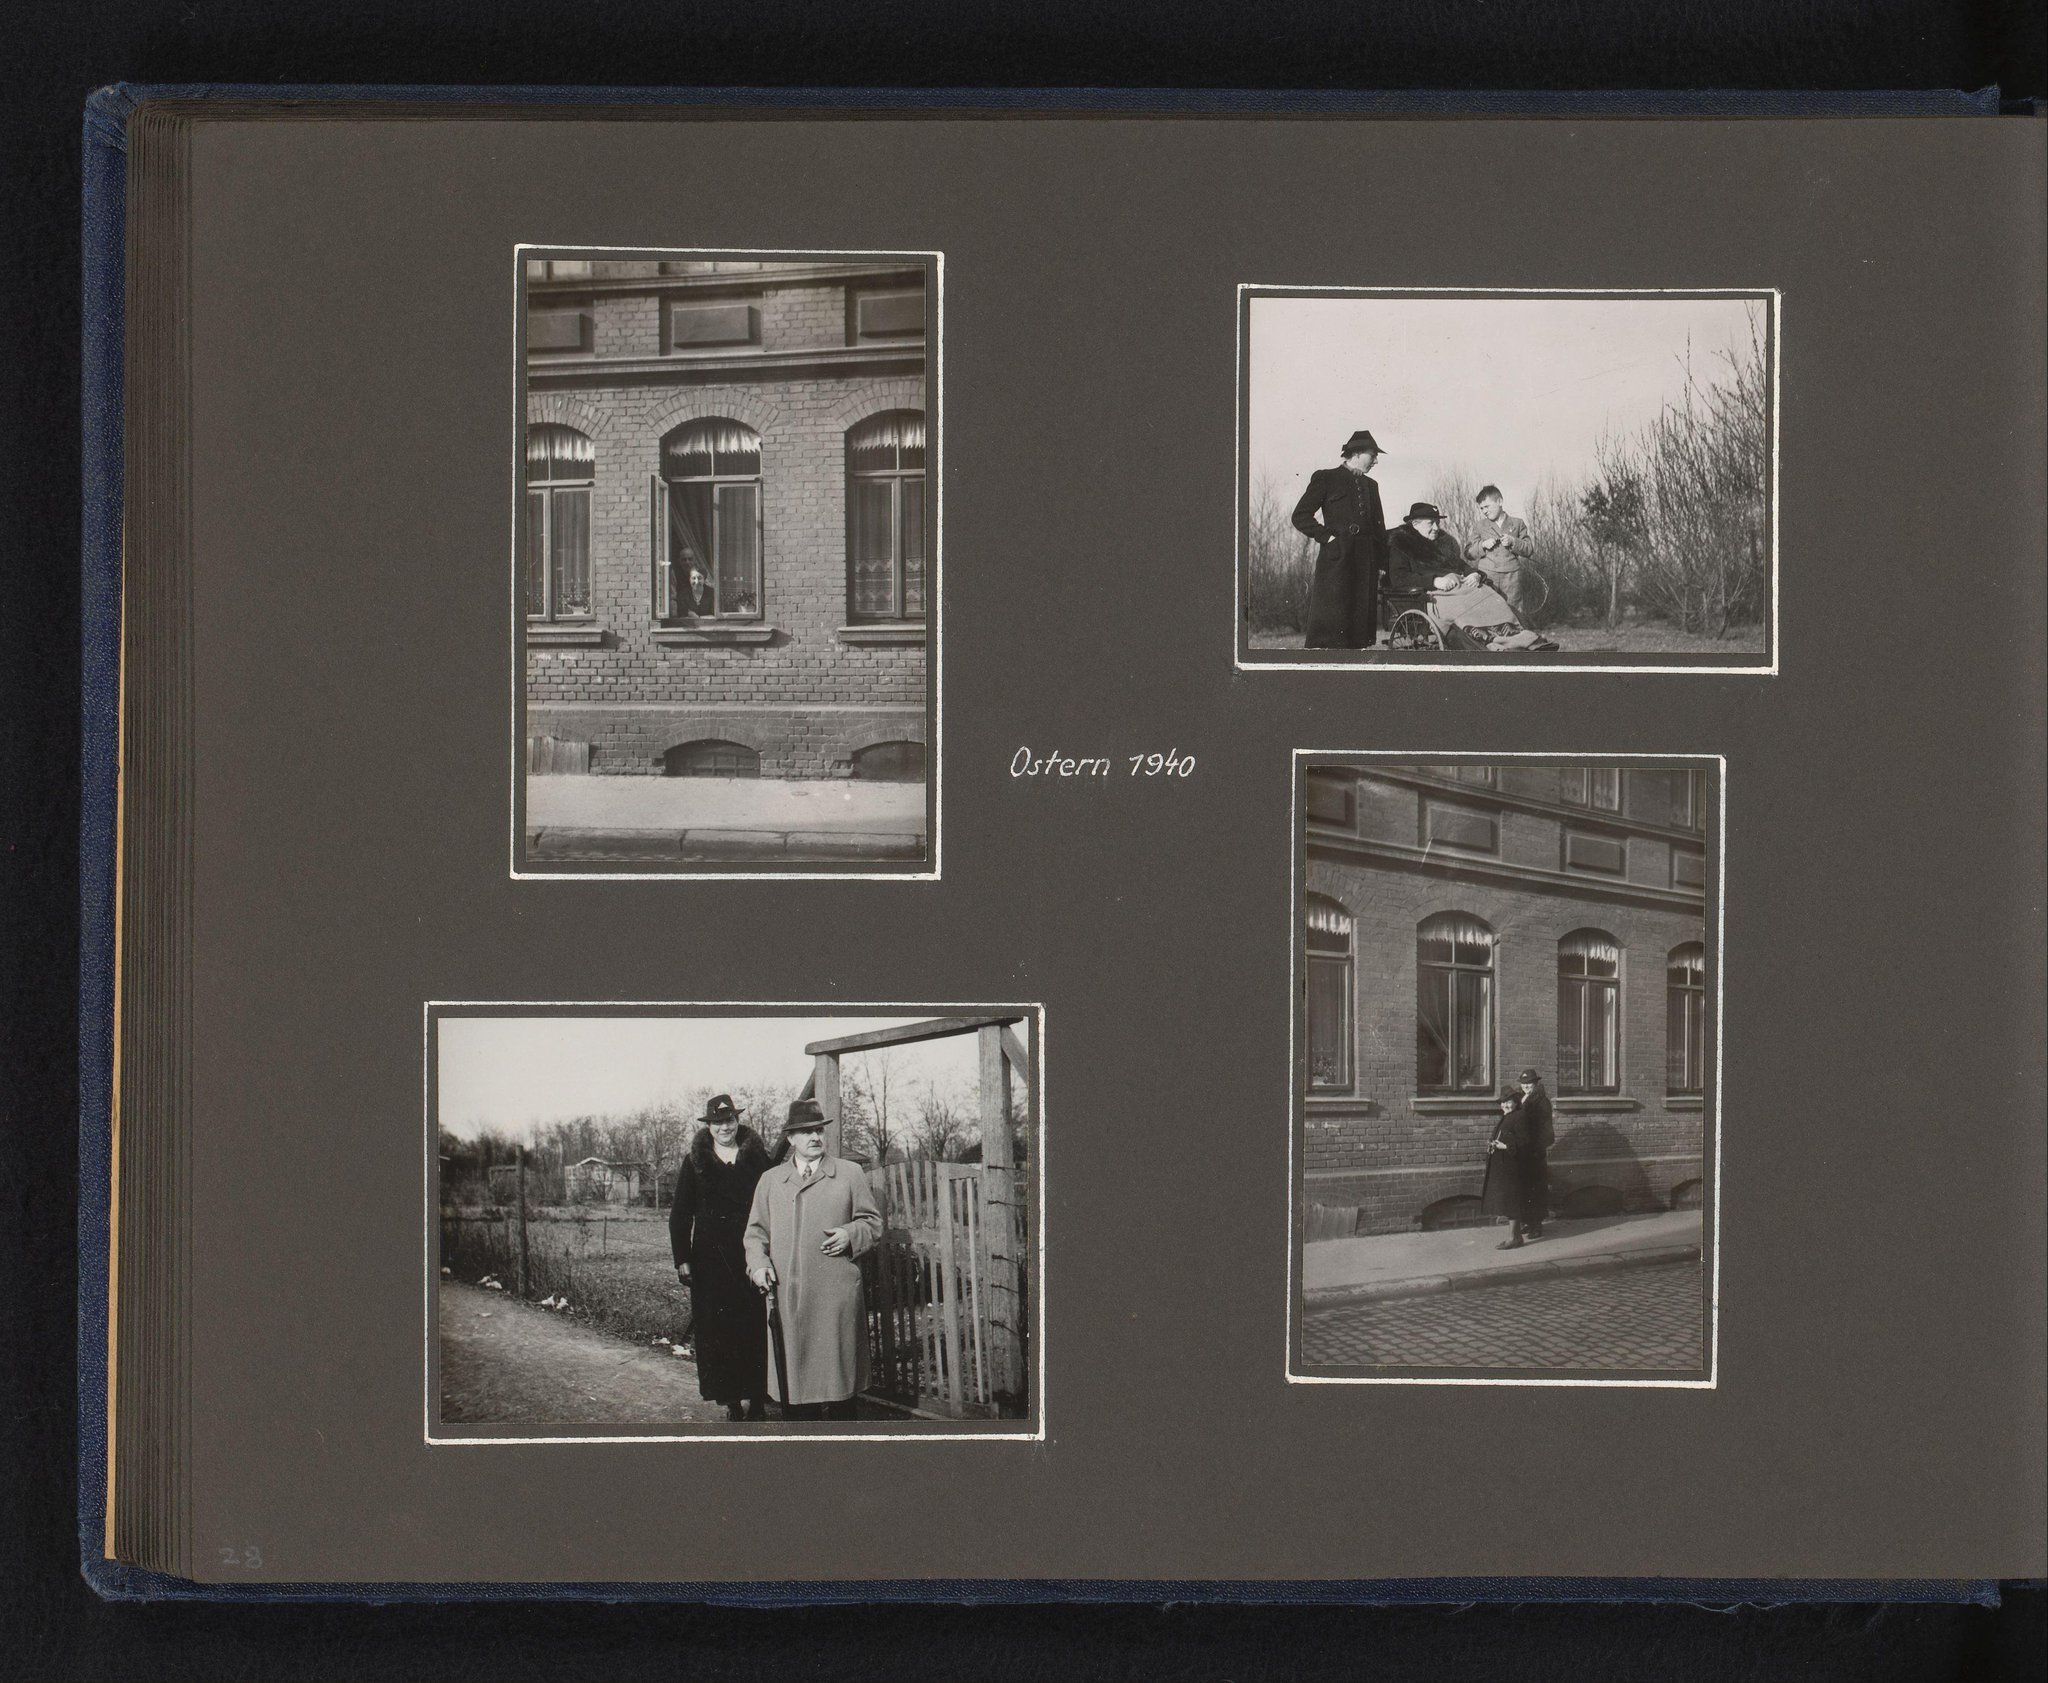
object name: photograph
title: Paasverlof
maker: Anonymous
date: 1940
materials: paper, photographic support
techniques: gelatin silver print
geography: germany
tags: leave ~ the soldier off duty, germany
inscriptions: inscription: ‘Ostern 1940’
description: Albumblad met drie vier foto's van familiebezoek tijdens verlof met Pasen, 1940. Onderdeel van een Duits militair album Tweede Wereldoorlog 1939-1940.